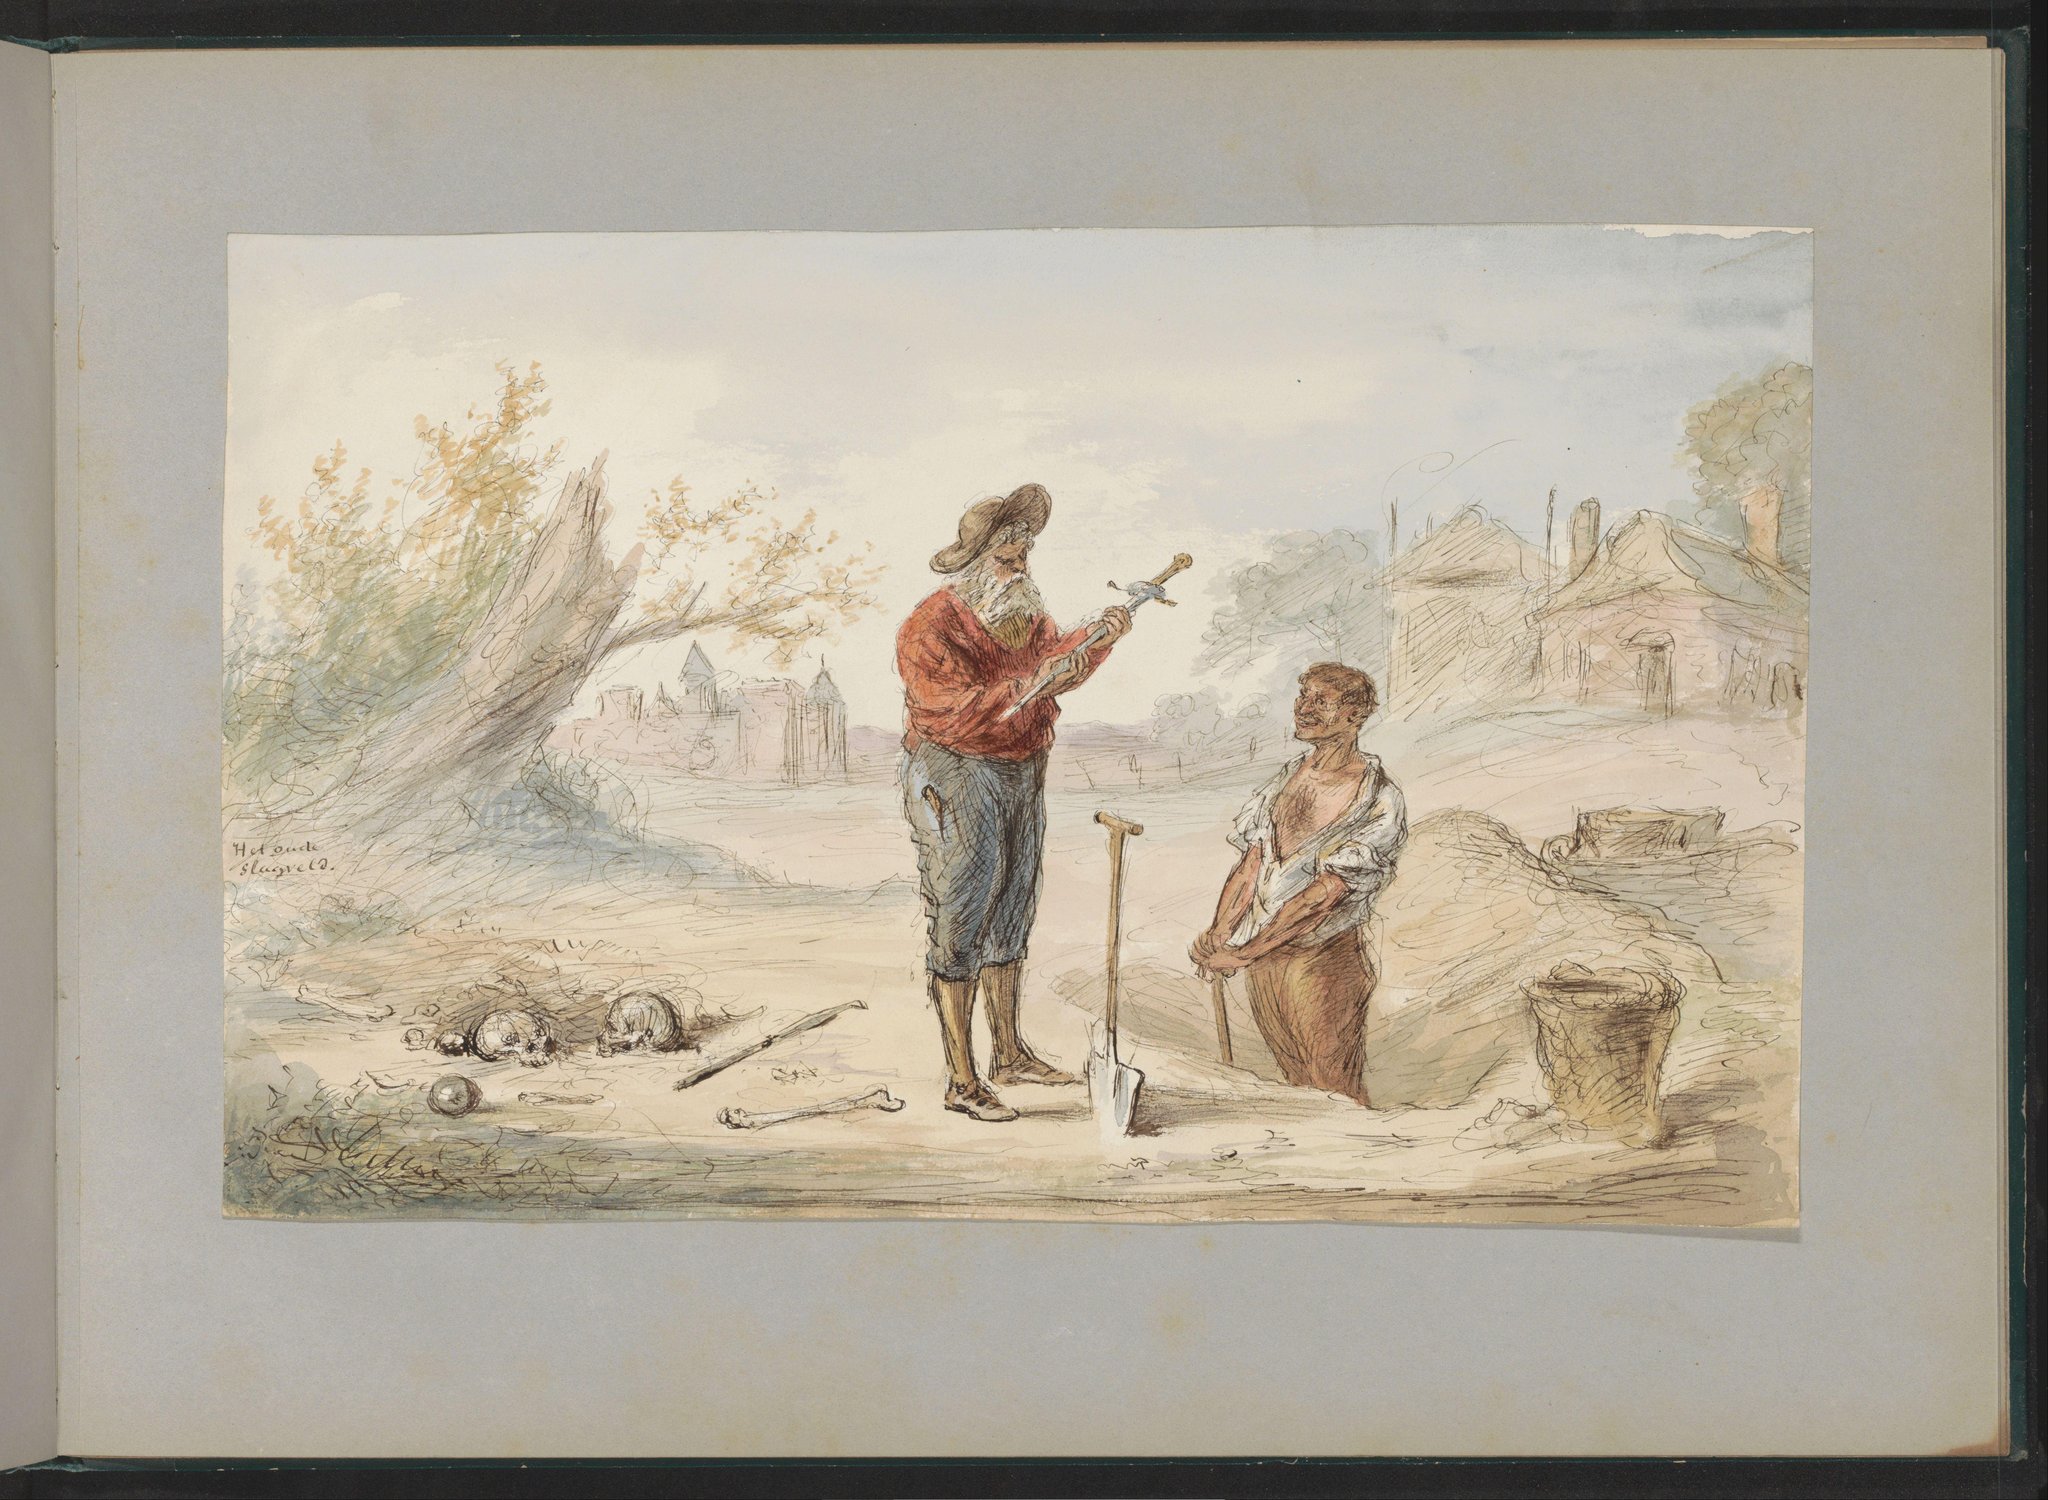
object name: album leaf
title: Man die een zwaard opgraaft op een oud slagveld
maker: alexander ver huell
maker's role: draughtsman, print maker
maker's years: 1822-1897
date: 1854-1887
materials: ink, paper, watercolor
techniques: brush, pen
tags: excavation ~ archaeology (+ variant), hacking and thrusting weapons: sword, pit, hole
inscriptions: annotation: ‘Het oude/ slagveld.’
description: Op een zandvlakte staat een man met in een kuil. Hij heeft een schopin zijn handen en kijkt naar een man met baard die naast de kuil staat. Hij bestudeert het zwaard dat de man heeft opgegraven. Achter hem liggen botten en menselijke schedels. Op de achtergrond zijn huizen te zien. Tekening op blad 27 van een album met 35 tekeningen.